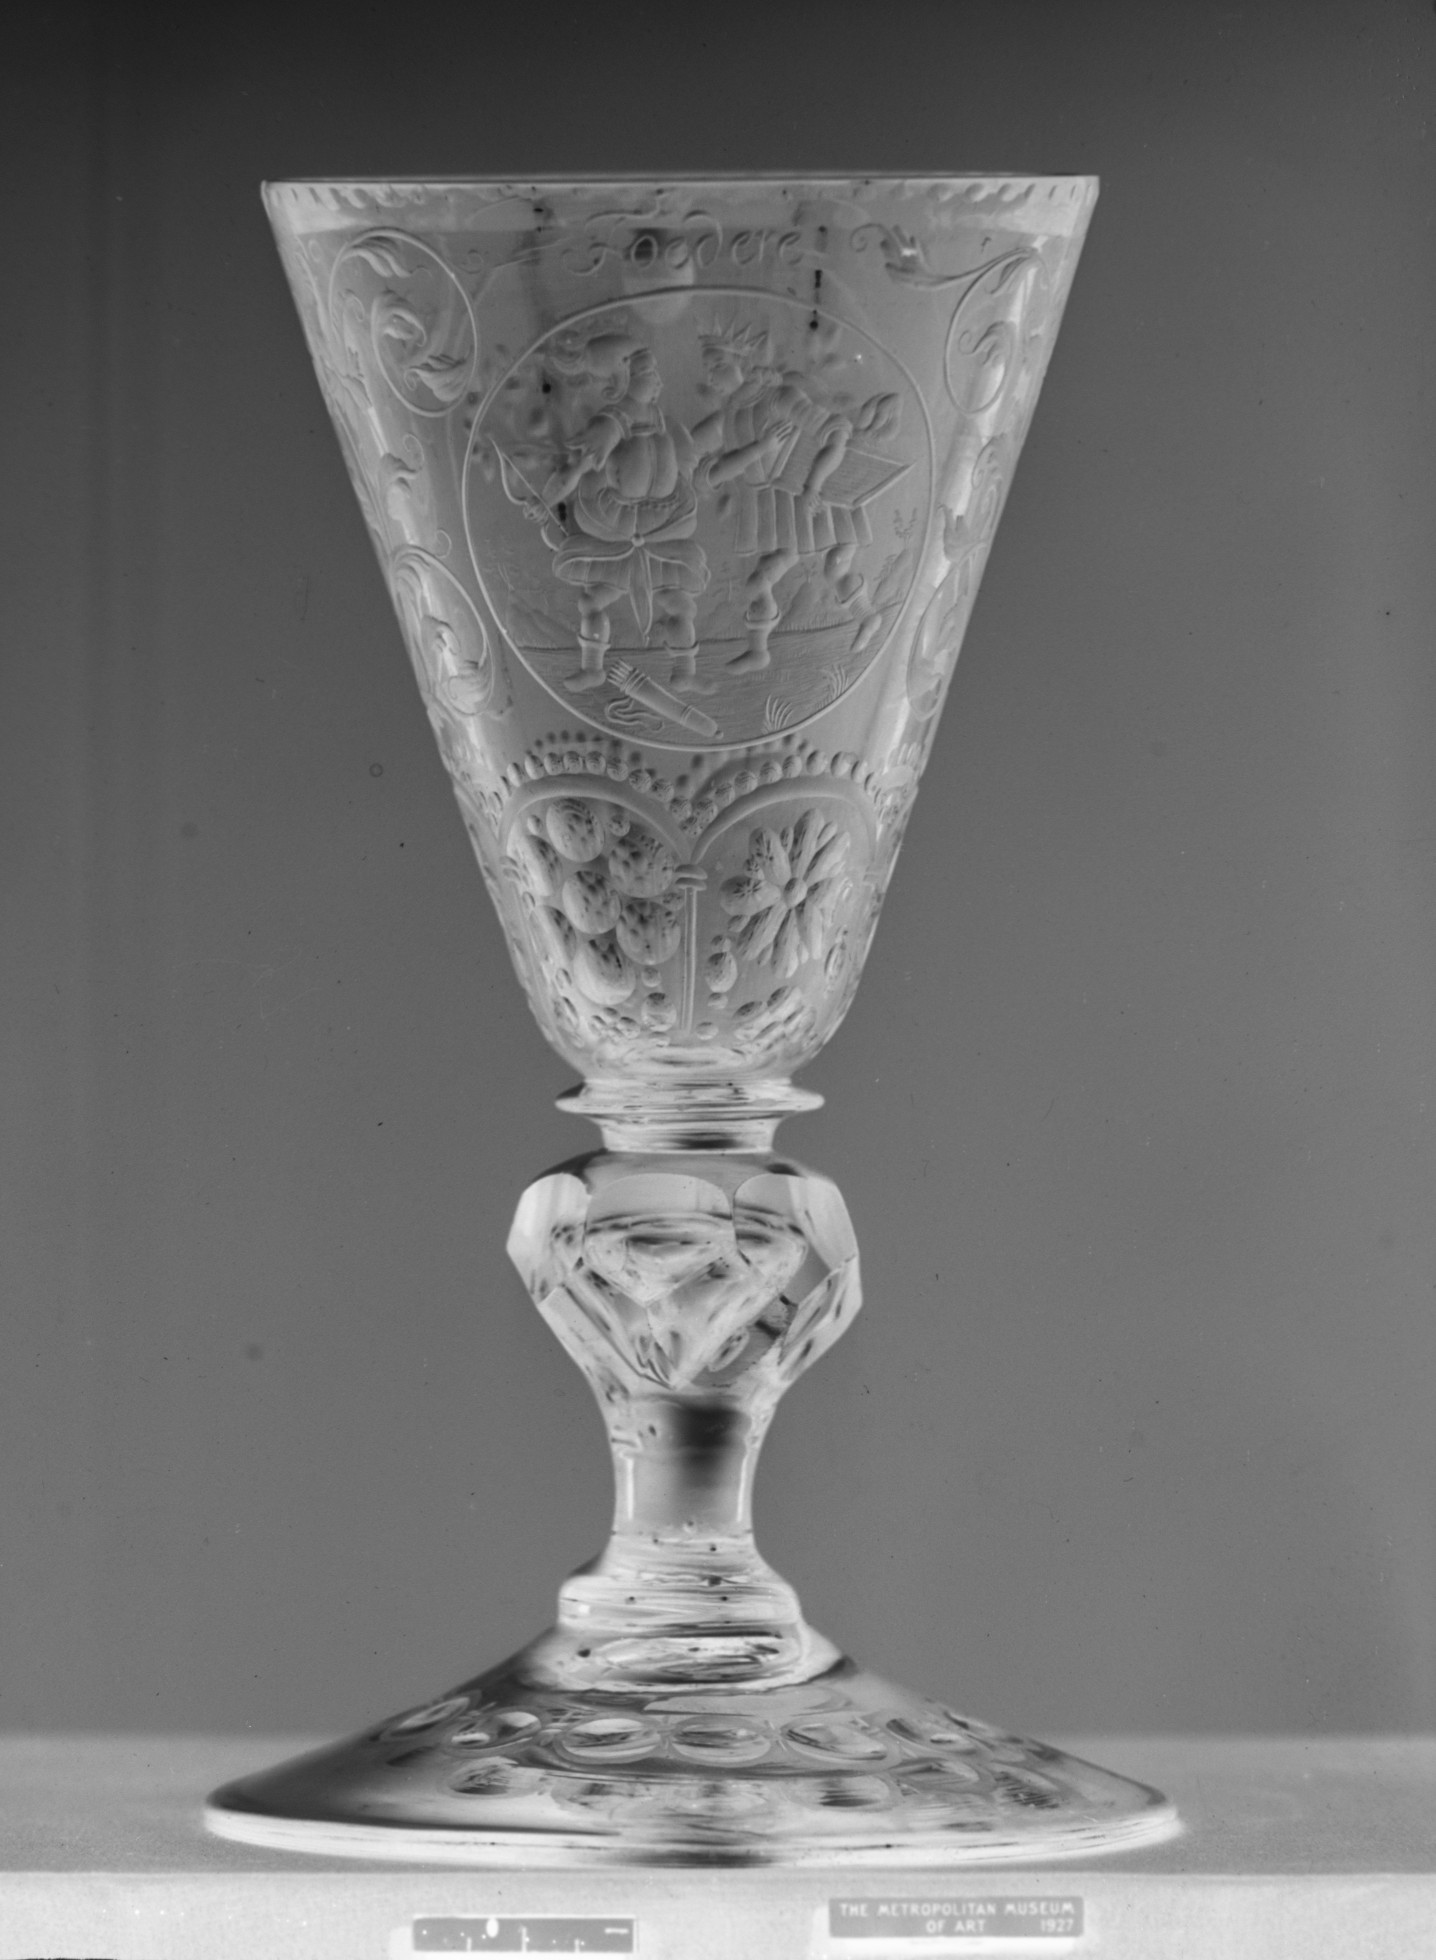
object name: wineglass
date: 1601-1700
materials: glass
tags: human figures